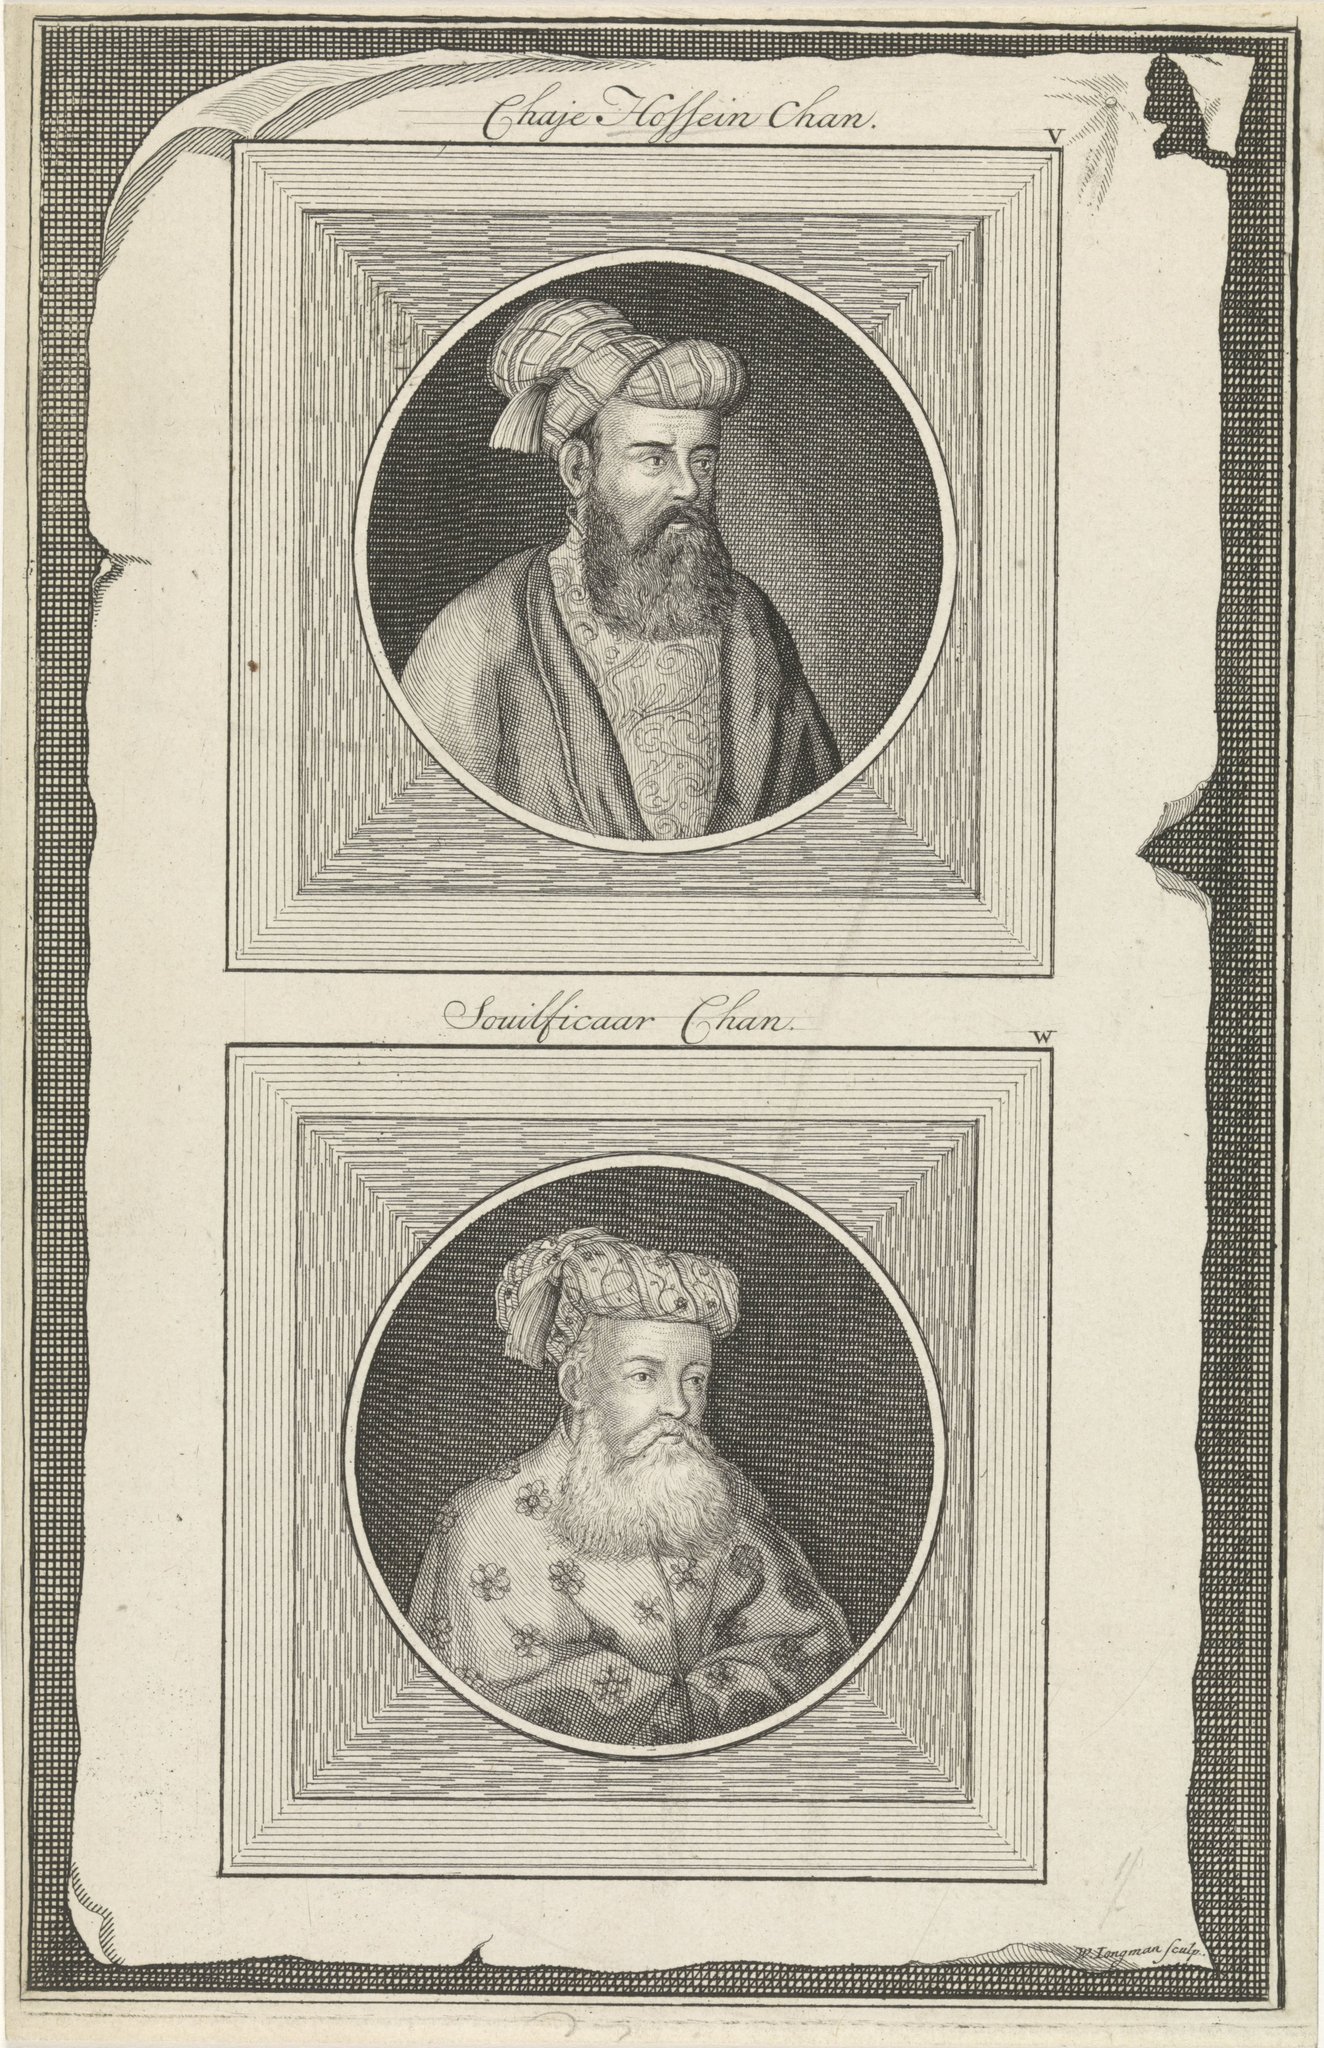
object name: print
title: Portretten van Chaje Hossein Chan en Souilficaar Chan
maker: wouter jongman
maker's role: print maker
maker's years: -1753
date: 1712-1744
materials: paper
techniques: engraving, etching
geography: amsterdam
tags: souilficaar chan, chaje hossein chan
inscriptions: collector's mark: Lugt 2228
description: Twee portretten op één blad. Boven: busteportret van Chaje Hossein Chan, met tulband, naar rechts. Onder: busteportret van Souilficaar Chan, met tulband en ketting, naar rechts. Beide portretten zijn gevat in een vierkante omlijsting met daarboven de naam van de geportretteerde.